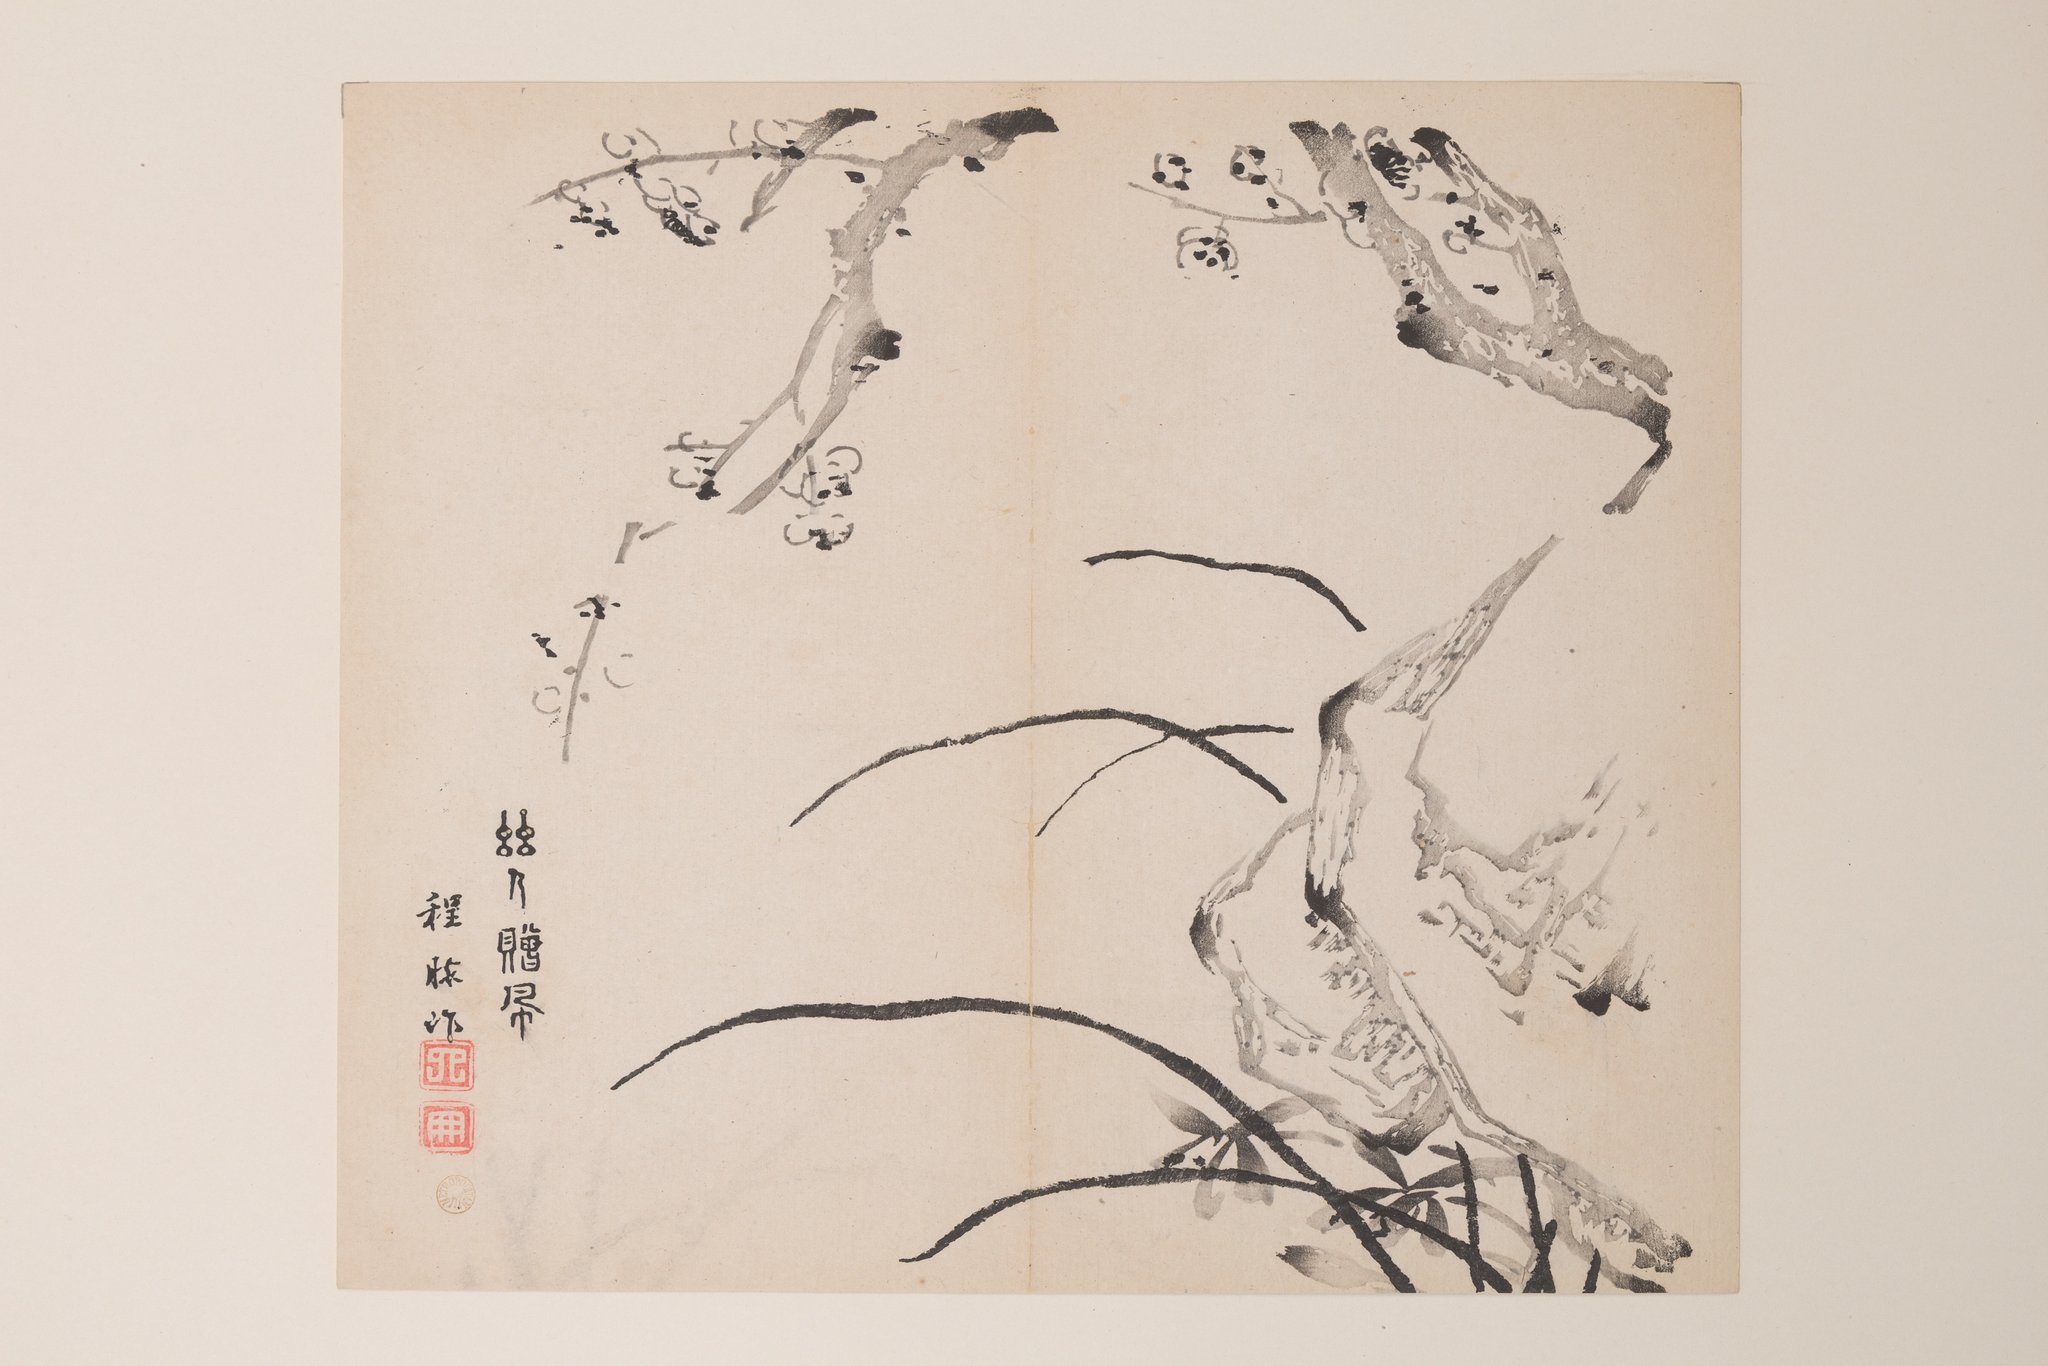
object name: print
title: Page from Shi Zhu Zhai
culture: chinese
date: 1662-1722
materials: ink, paper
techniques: polychrome, woodblock print